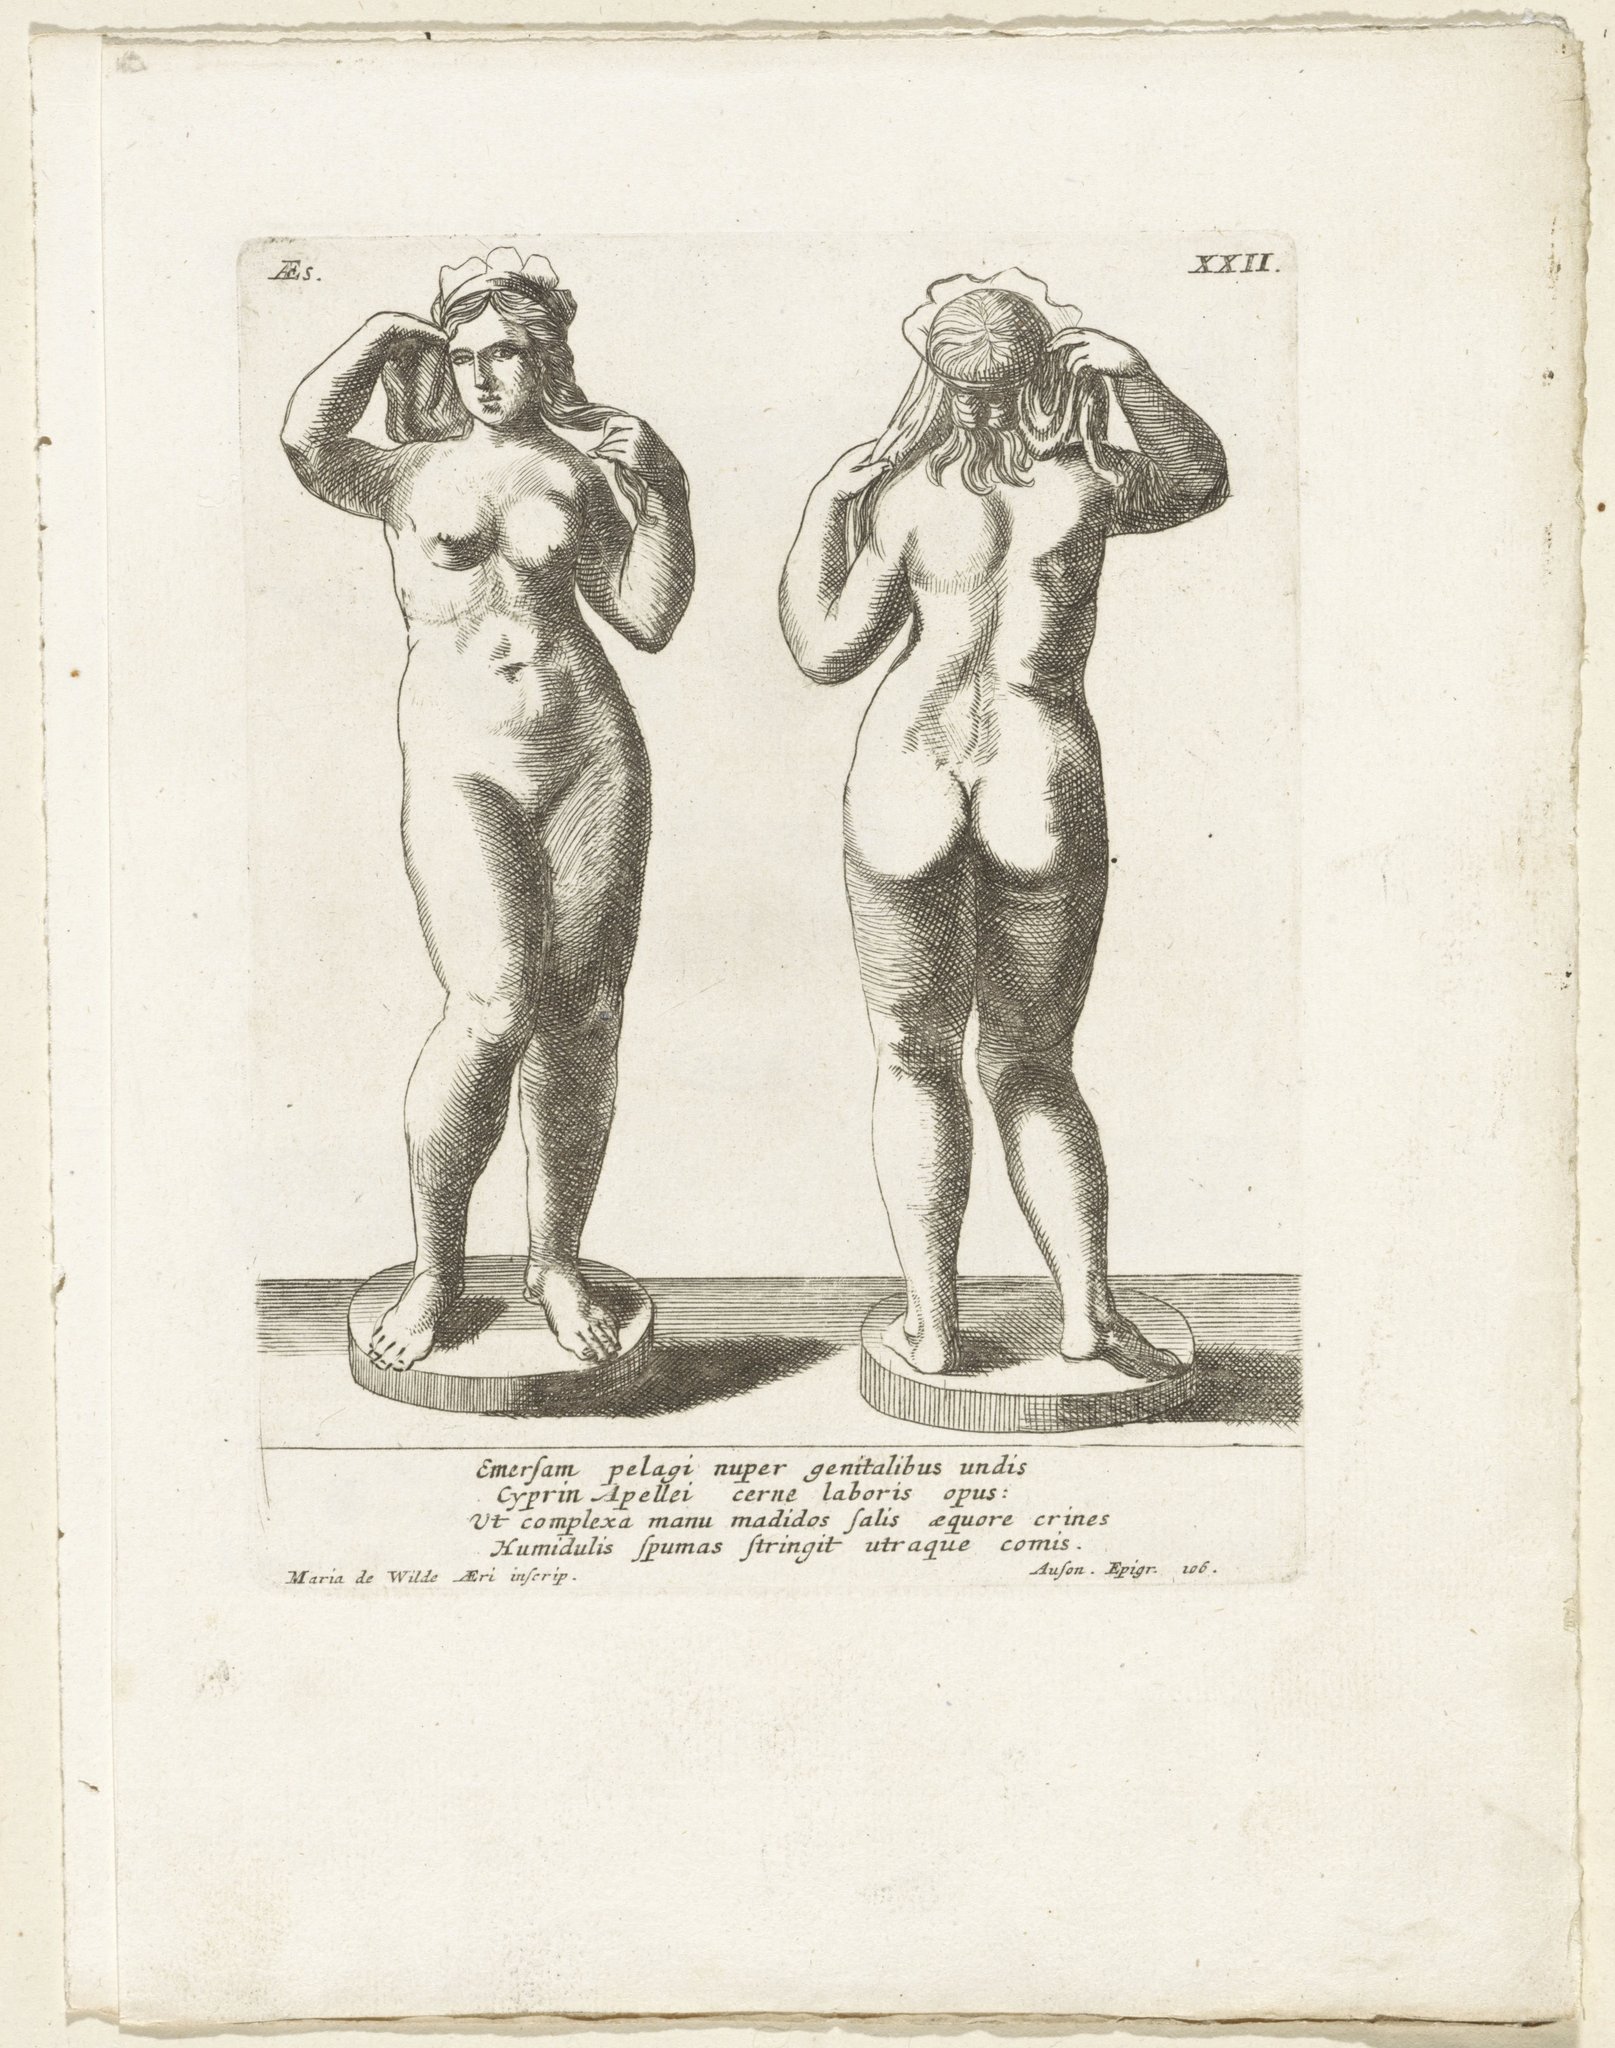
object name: book illustration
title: Voor- en achteraanzicht van een Venusbeeld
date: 1700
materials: paper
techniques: etching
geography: amsterdam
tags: piece of sculpture, reproduction of a piece of sculpture, (story of) venus (aphrodite)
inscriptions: collector's mark: Lugt 2760, collector's mark: Lugt 2228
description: De prent is gebruikt als boekillustratie in: Wilde, Maria de. Signa antiqua, e museo Jacobi de Wilde per Mariam filiam aeri inscripta, Amsterdam: Maria de Wilde, 1700. Volgens Hollstein is het een prent naar een Romeins bronzen beeld.